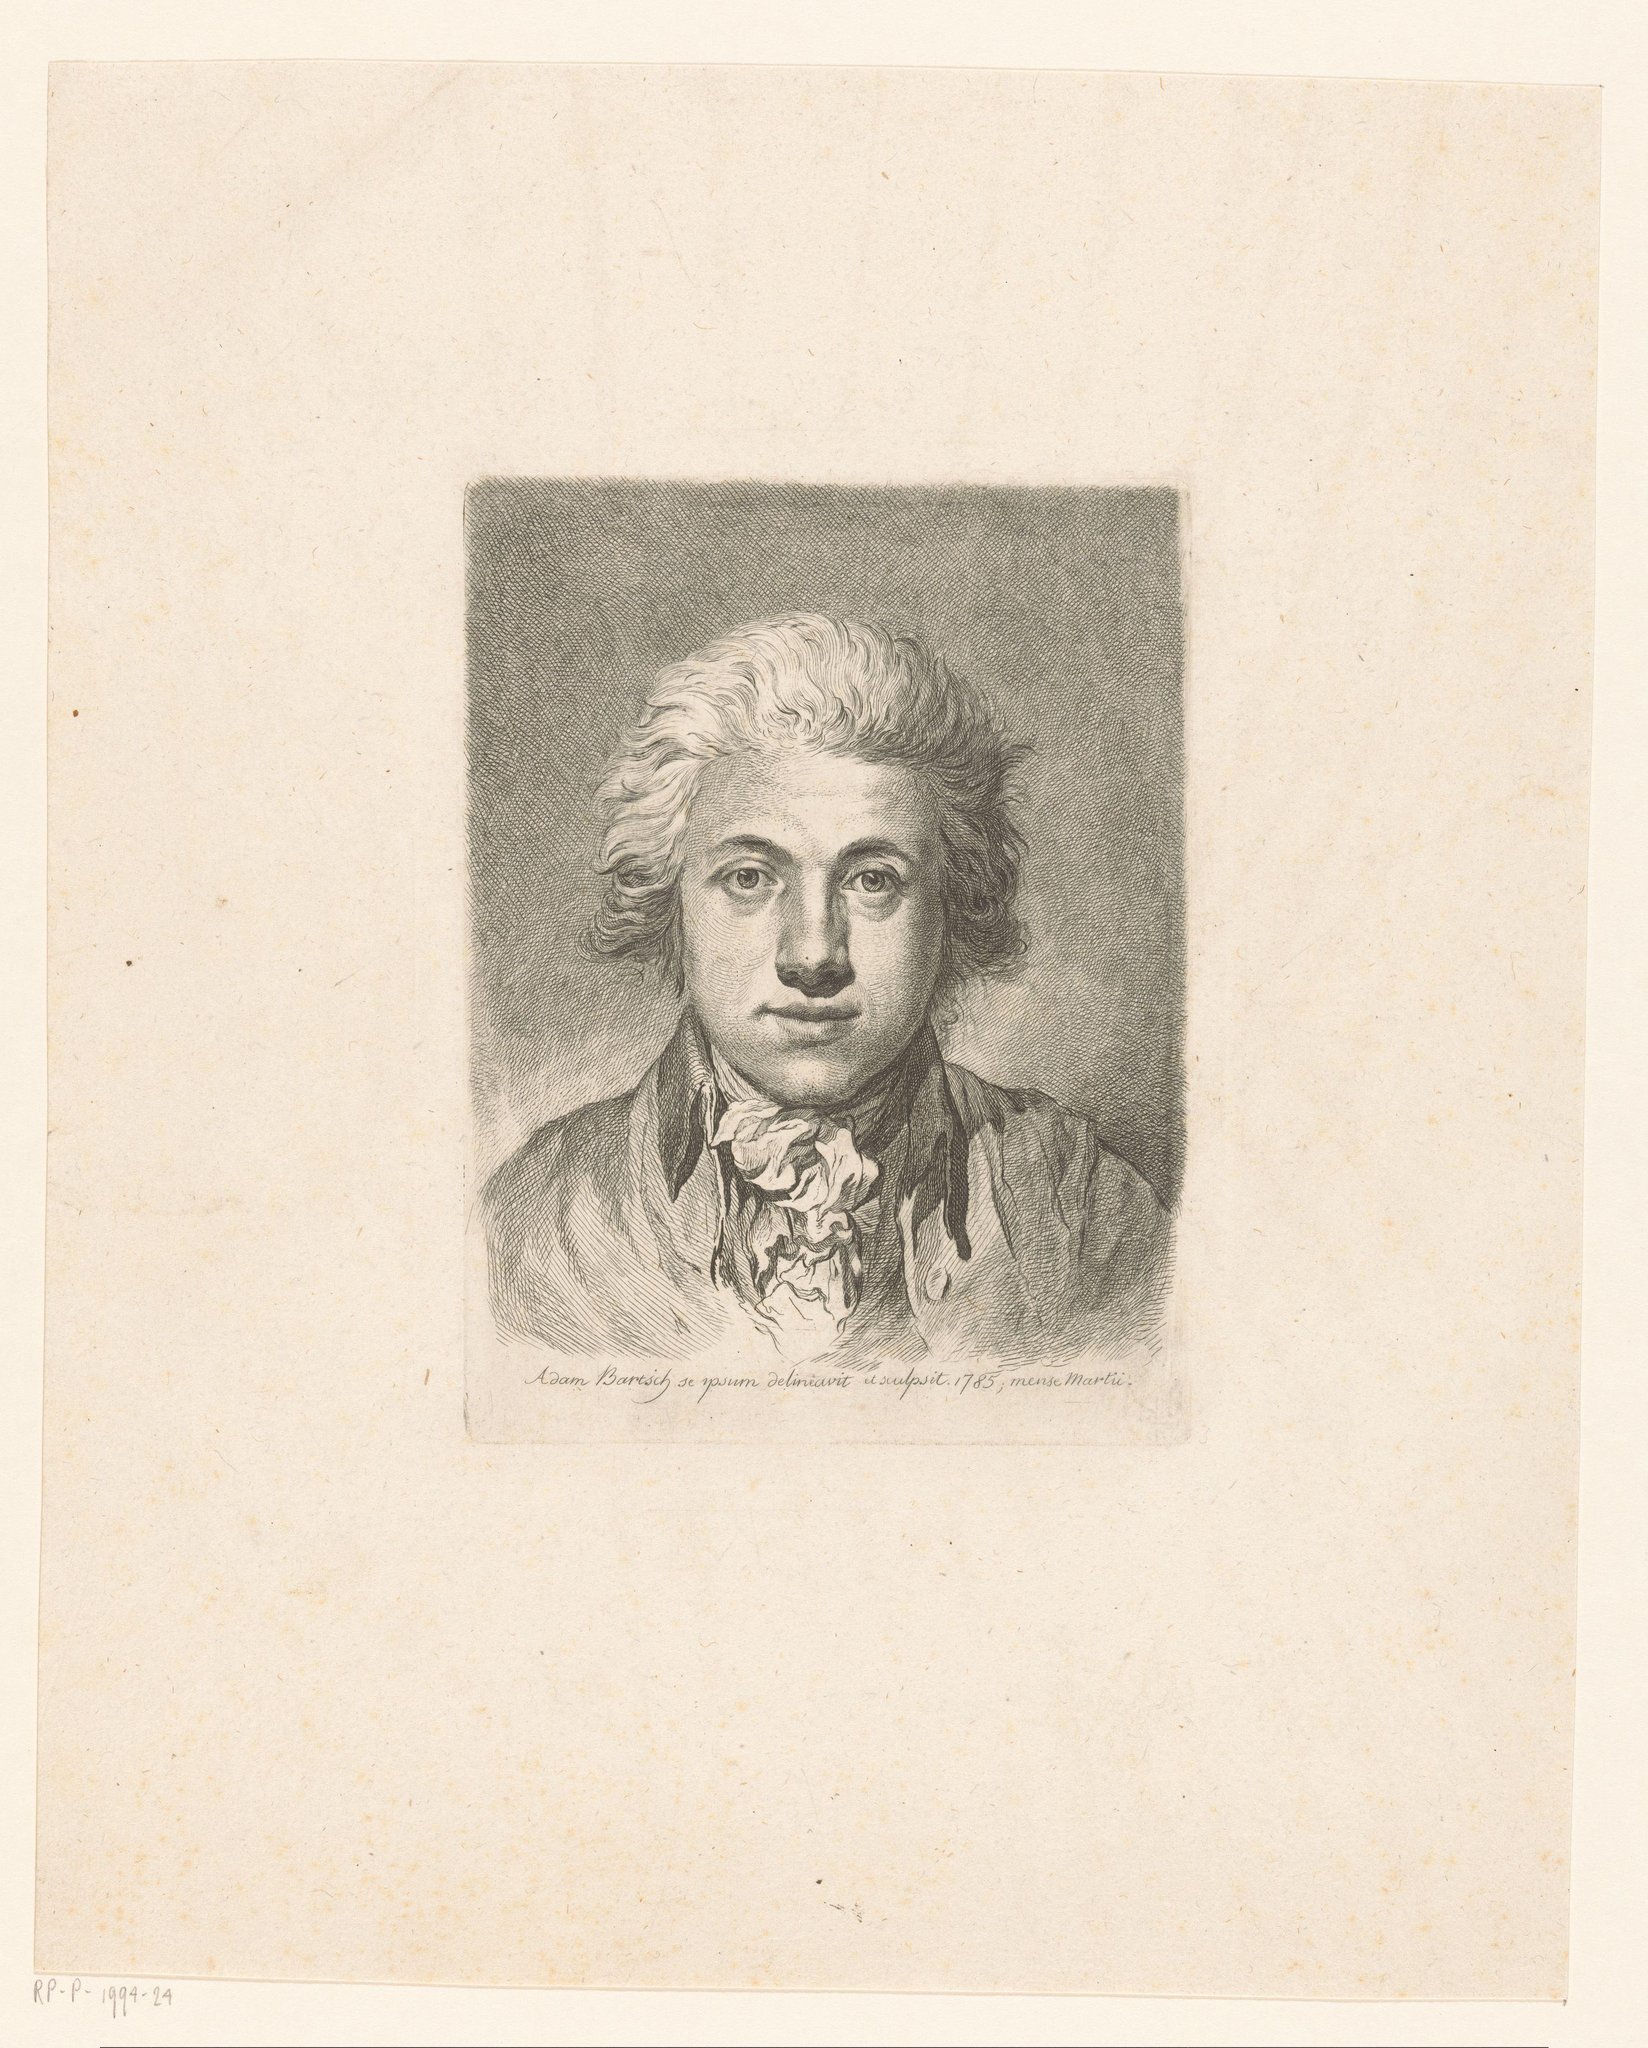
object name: print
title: Zelfportret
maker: adam von bartsch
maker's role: print maker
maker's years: 1757-1821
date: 1703-1785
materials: paper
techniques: engraving, etching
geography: vienna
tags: vienna, print maker, adam von bartsch, portrait, self-portrait of artist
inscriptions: collector's mark: Lugt 2228